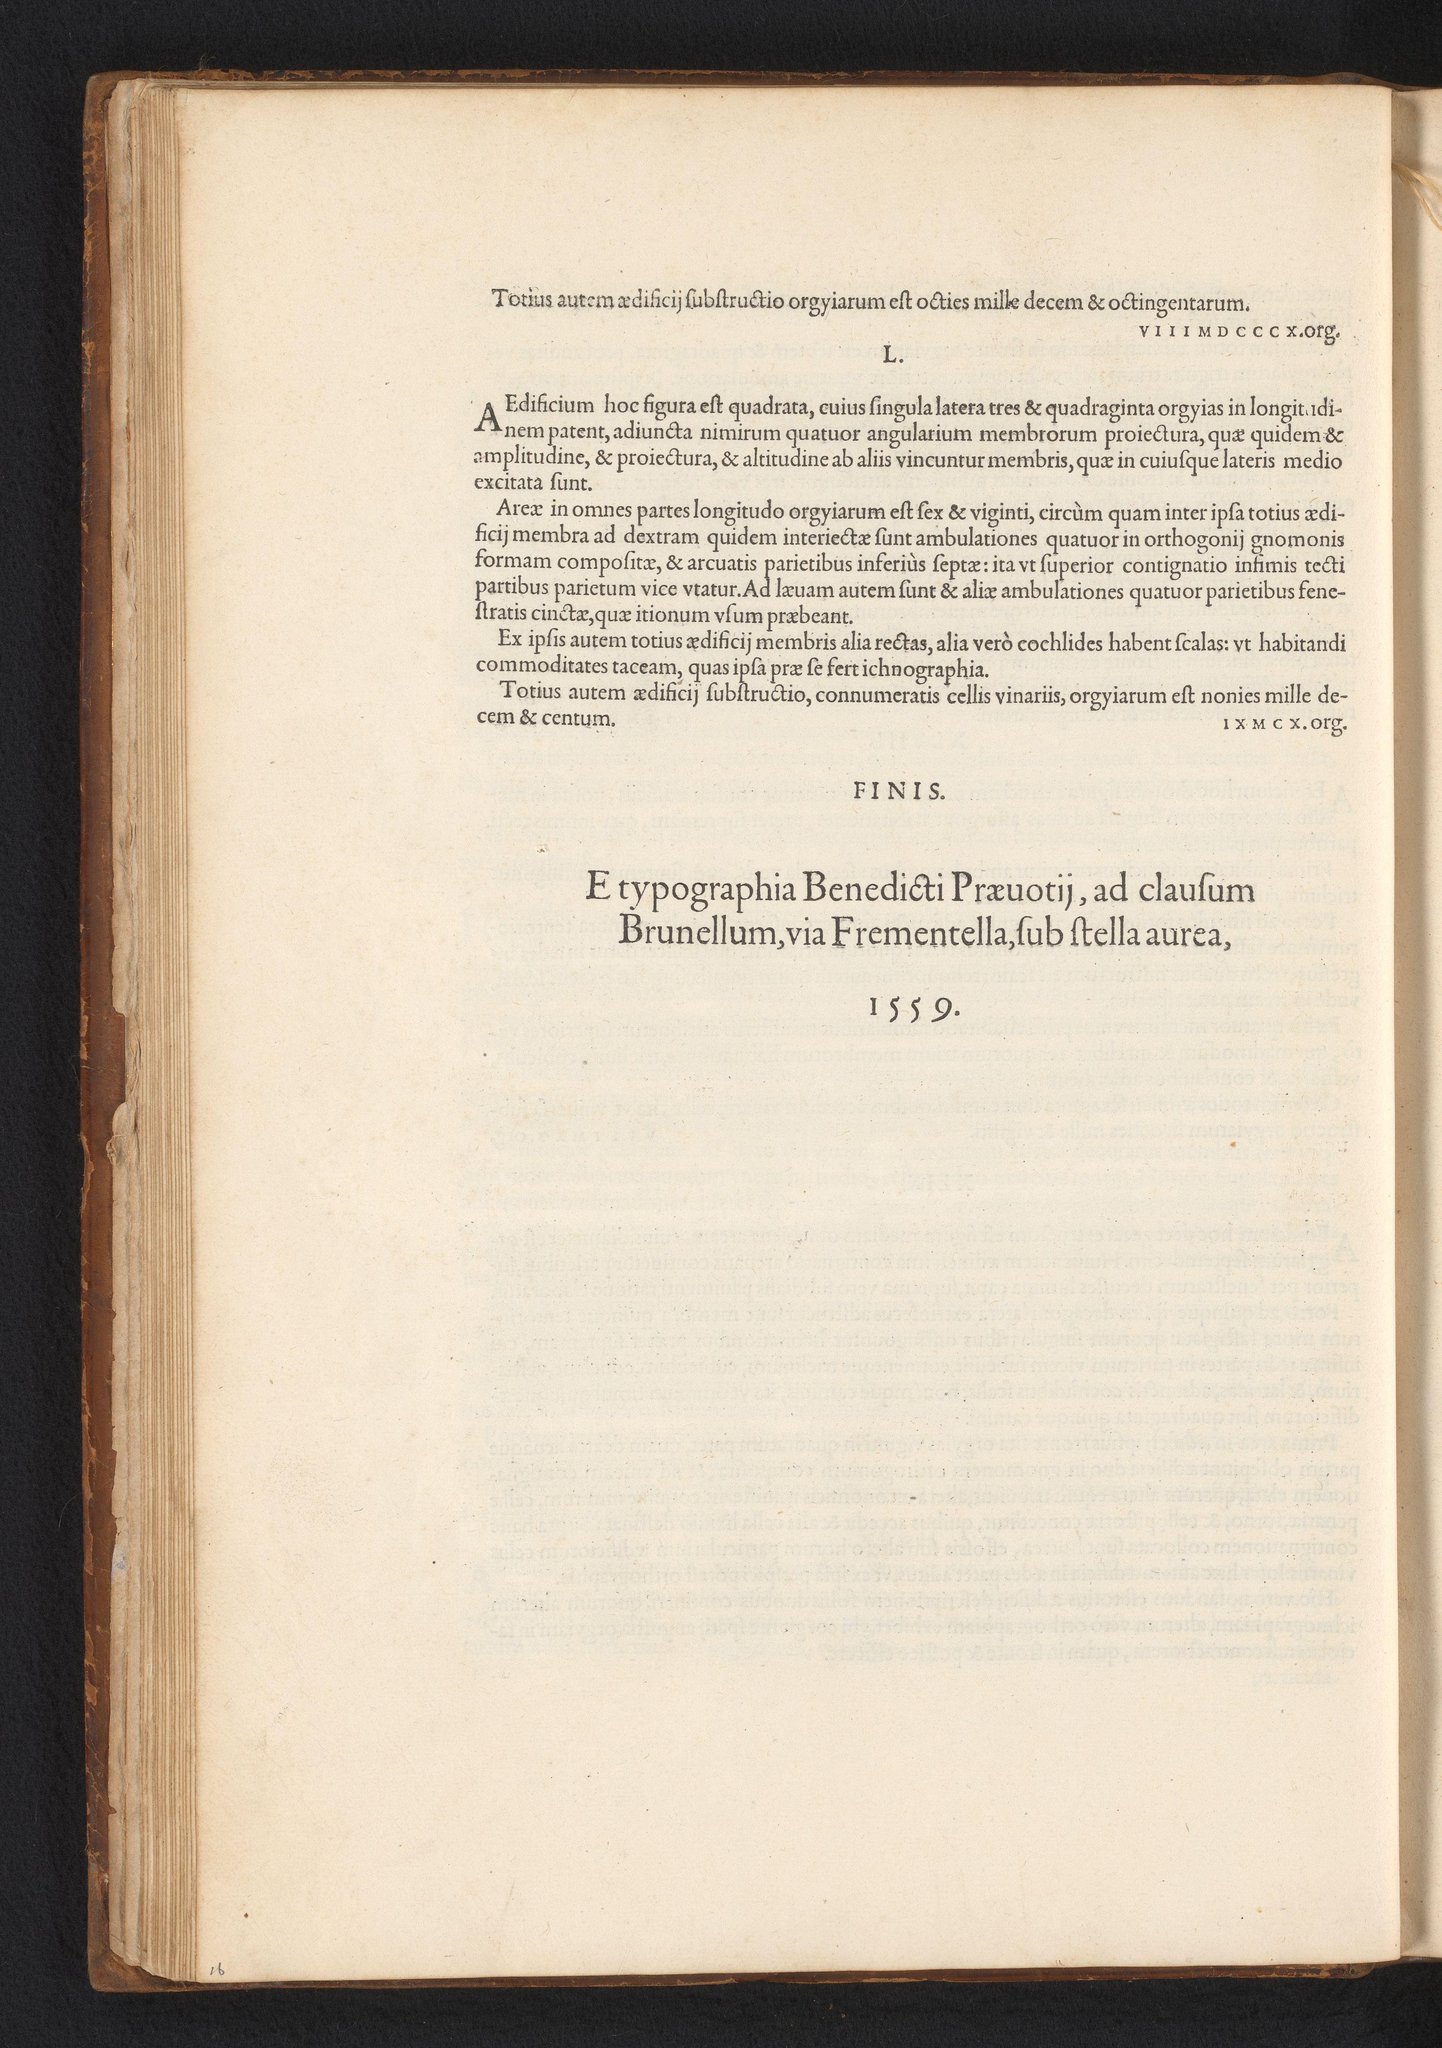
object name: text sheet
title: Colofon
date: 1559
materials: paper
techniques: letterpress printing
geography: paris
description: Colofon. Laatste bladzijde van de inleiding. Met vermelding van de drukker en datum. Onderdeel van 'De architectura Iacobi Androuetii du Cerceau' (1559): 69 etsen met 171 voorstellingen van architectuur en ornamentiek.